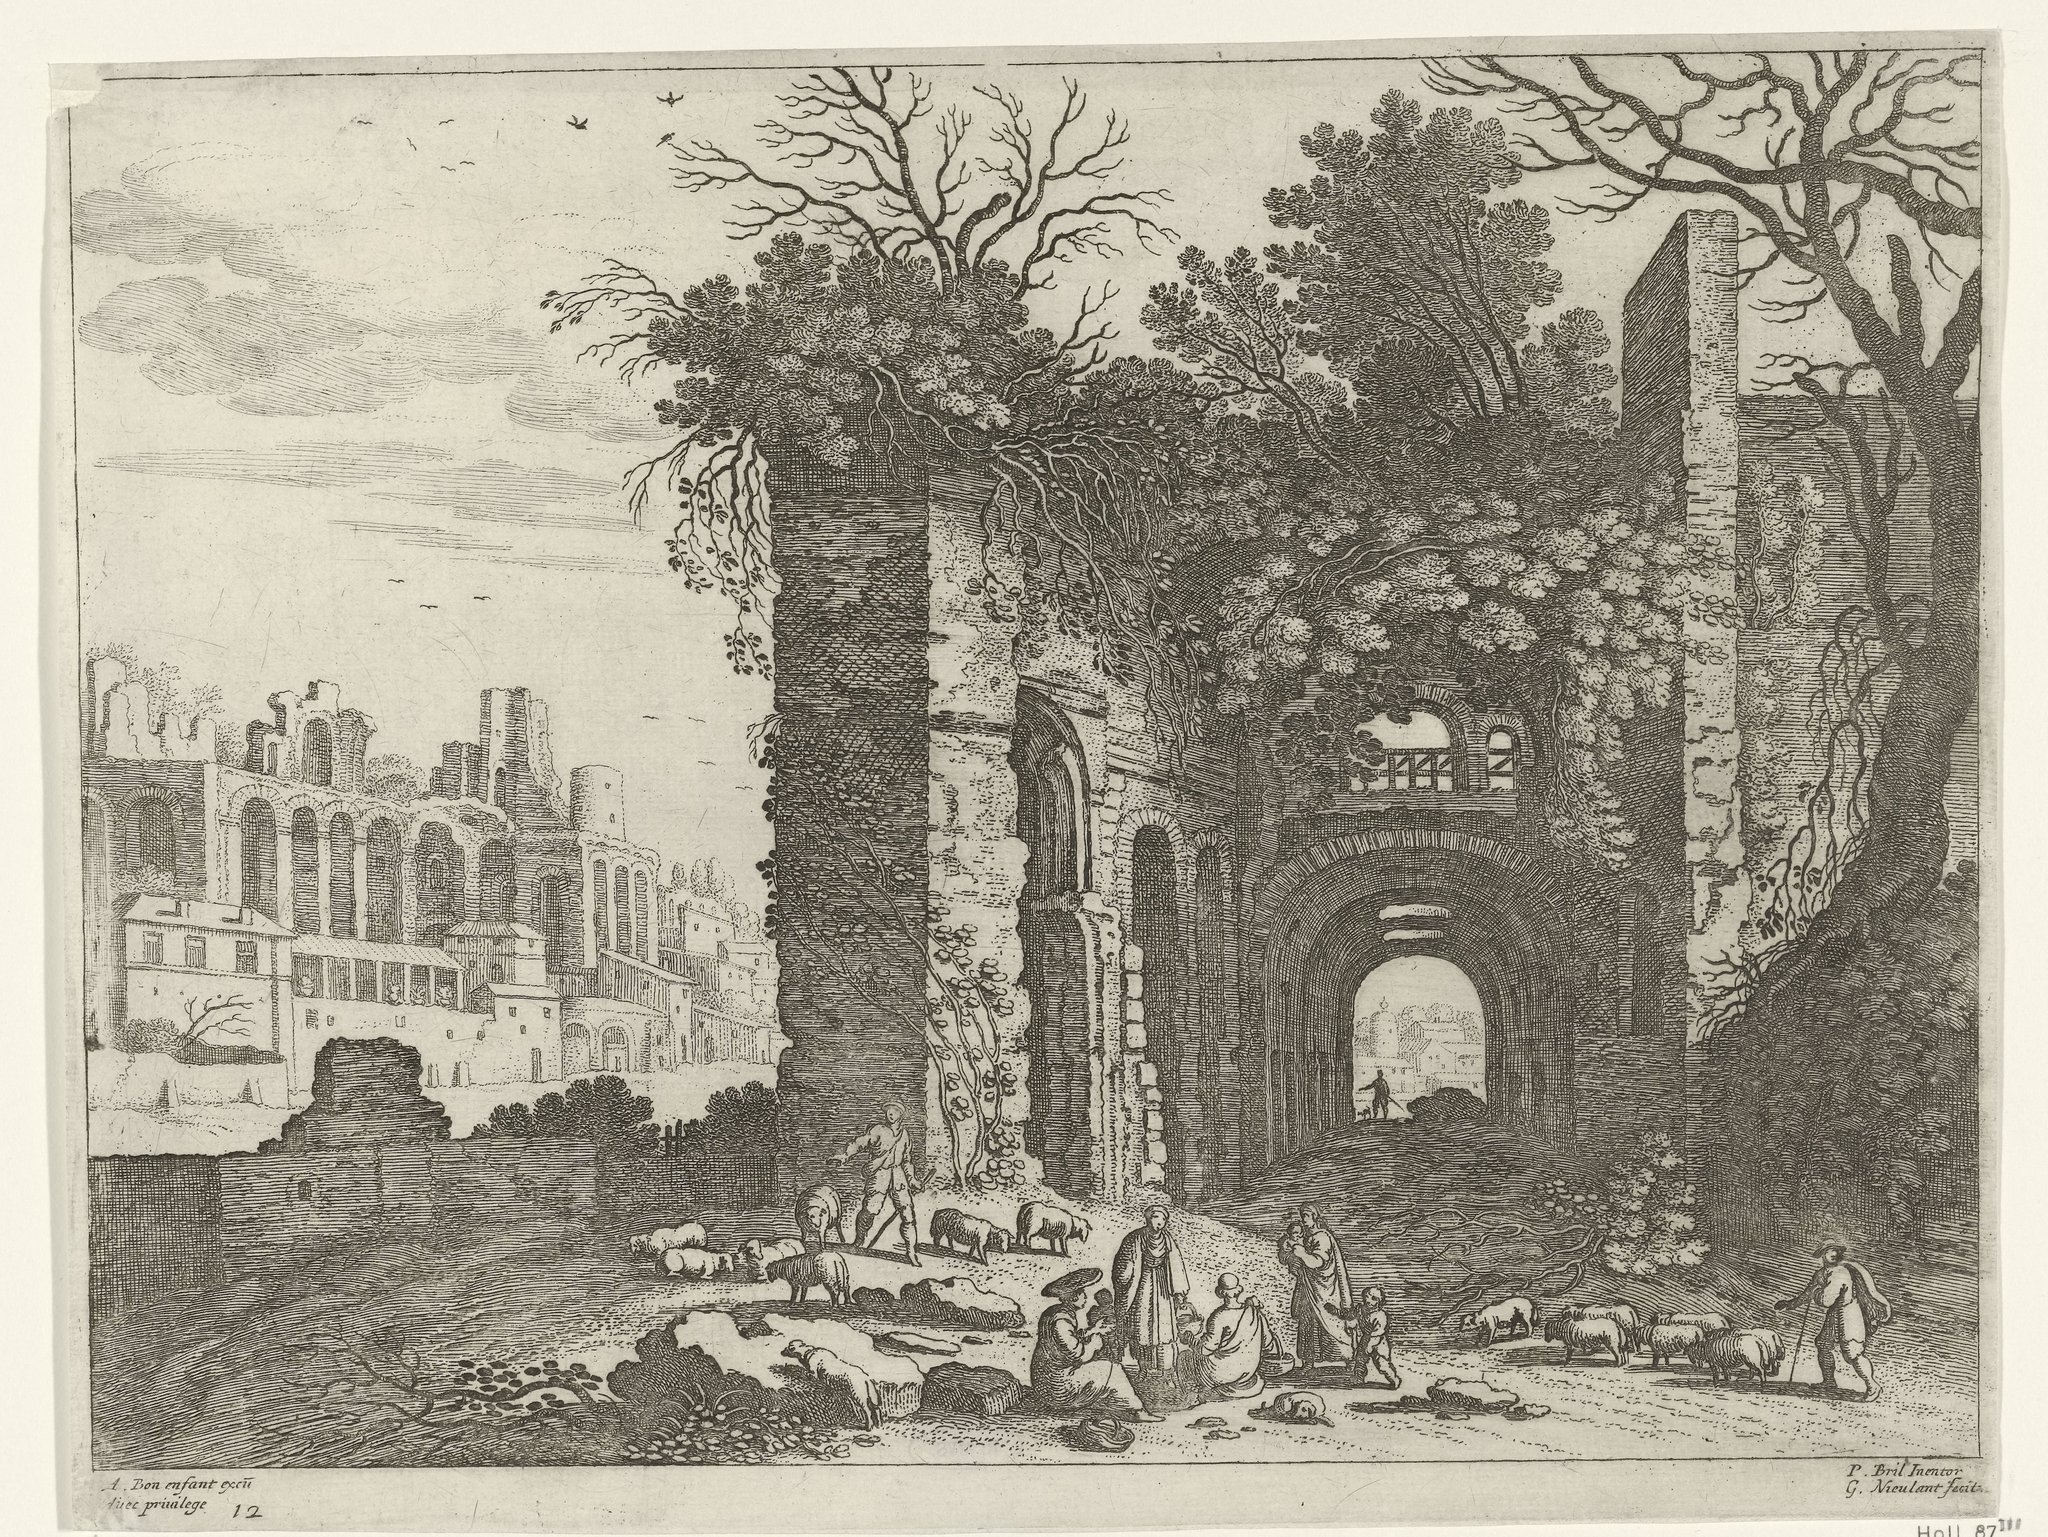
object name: print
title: Rustende familie voor een ruïne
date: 1594-1635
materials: paper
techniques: etching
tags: herding, herdsman, herdswoman, shepherd, shepherdess, cowherd, etc., landscape with ruins, family, relationship, descent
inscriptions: collector's mark: Lugt 2228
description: Voor een begroeide overwelfde ruïne een rustende familie en twee herders met hun kudde schapen. Links een ruïne met daaronder huizen. Prent uit een serie Italiaanse landschappen.